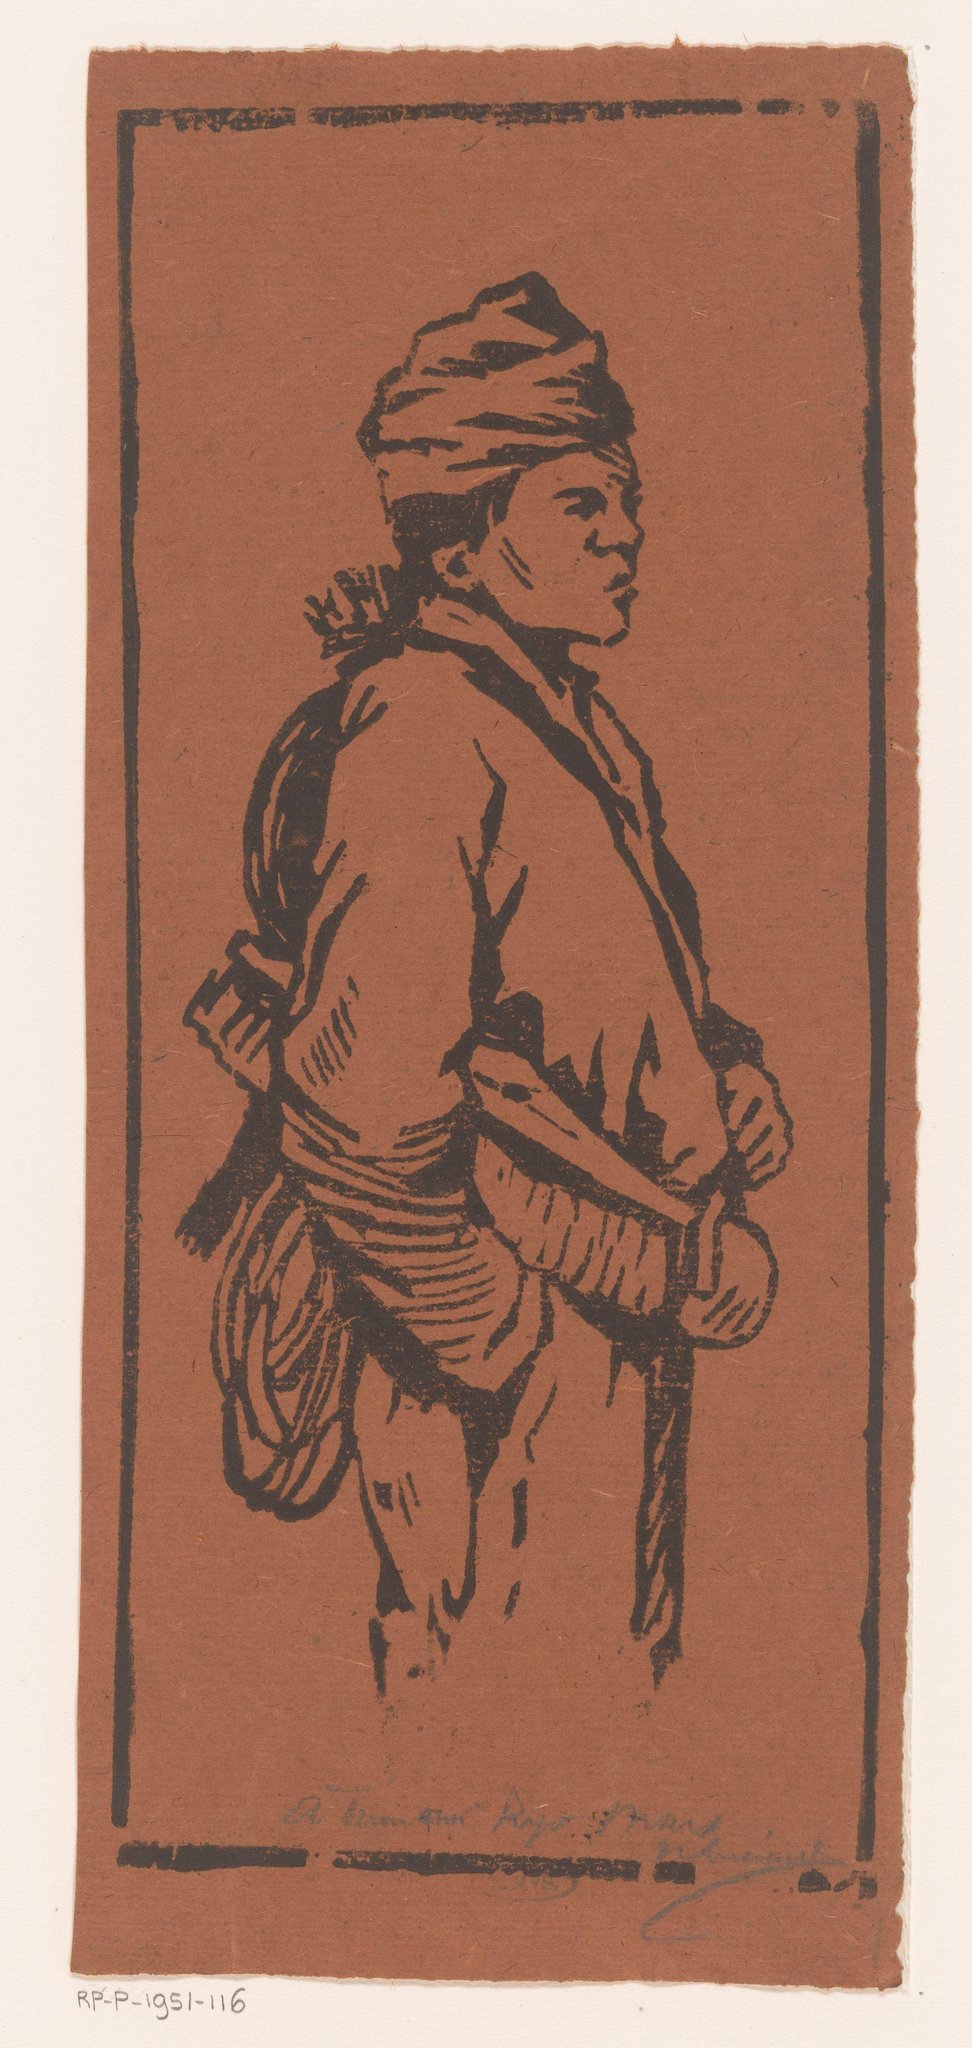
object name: print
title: Schoorsteenveger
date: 1890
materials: paper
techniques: woodcut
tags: handicrafts ~ maintenance and repair (with name of trade or profession)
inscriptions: annotation: ‘A monsieur Roger Marx/ H Guérard’, collector's mark: Lugt 2228